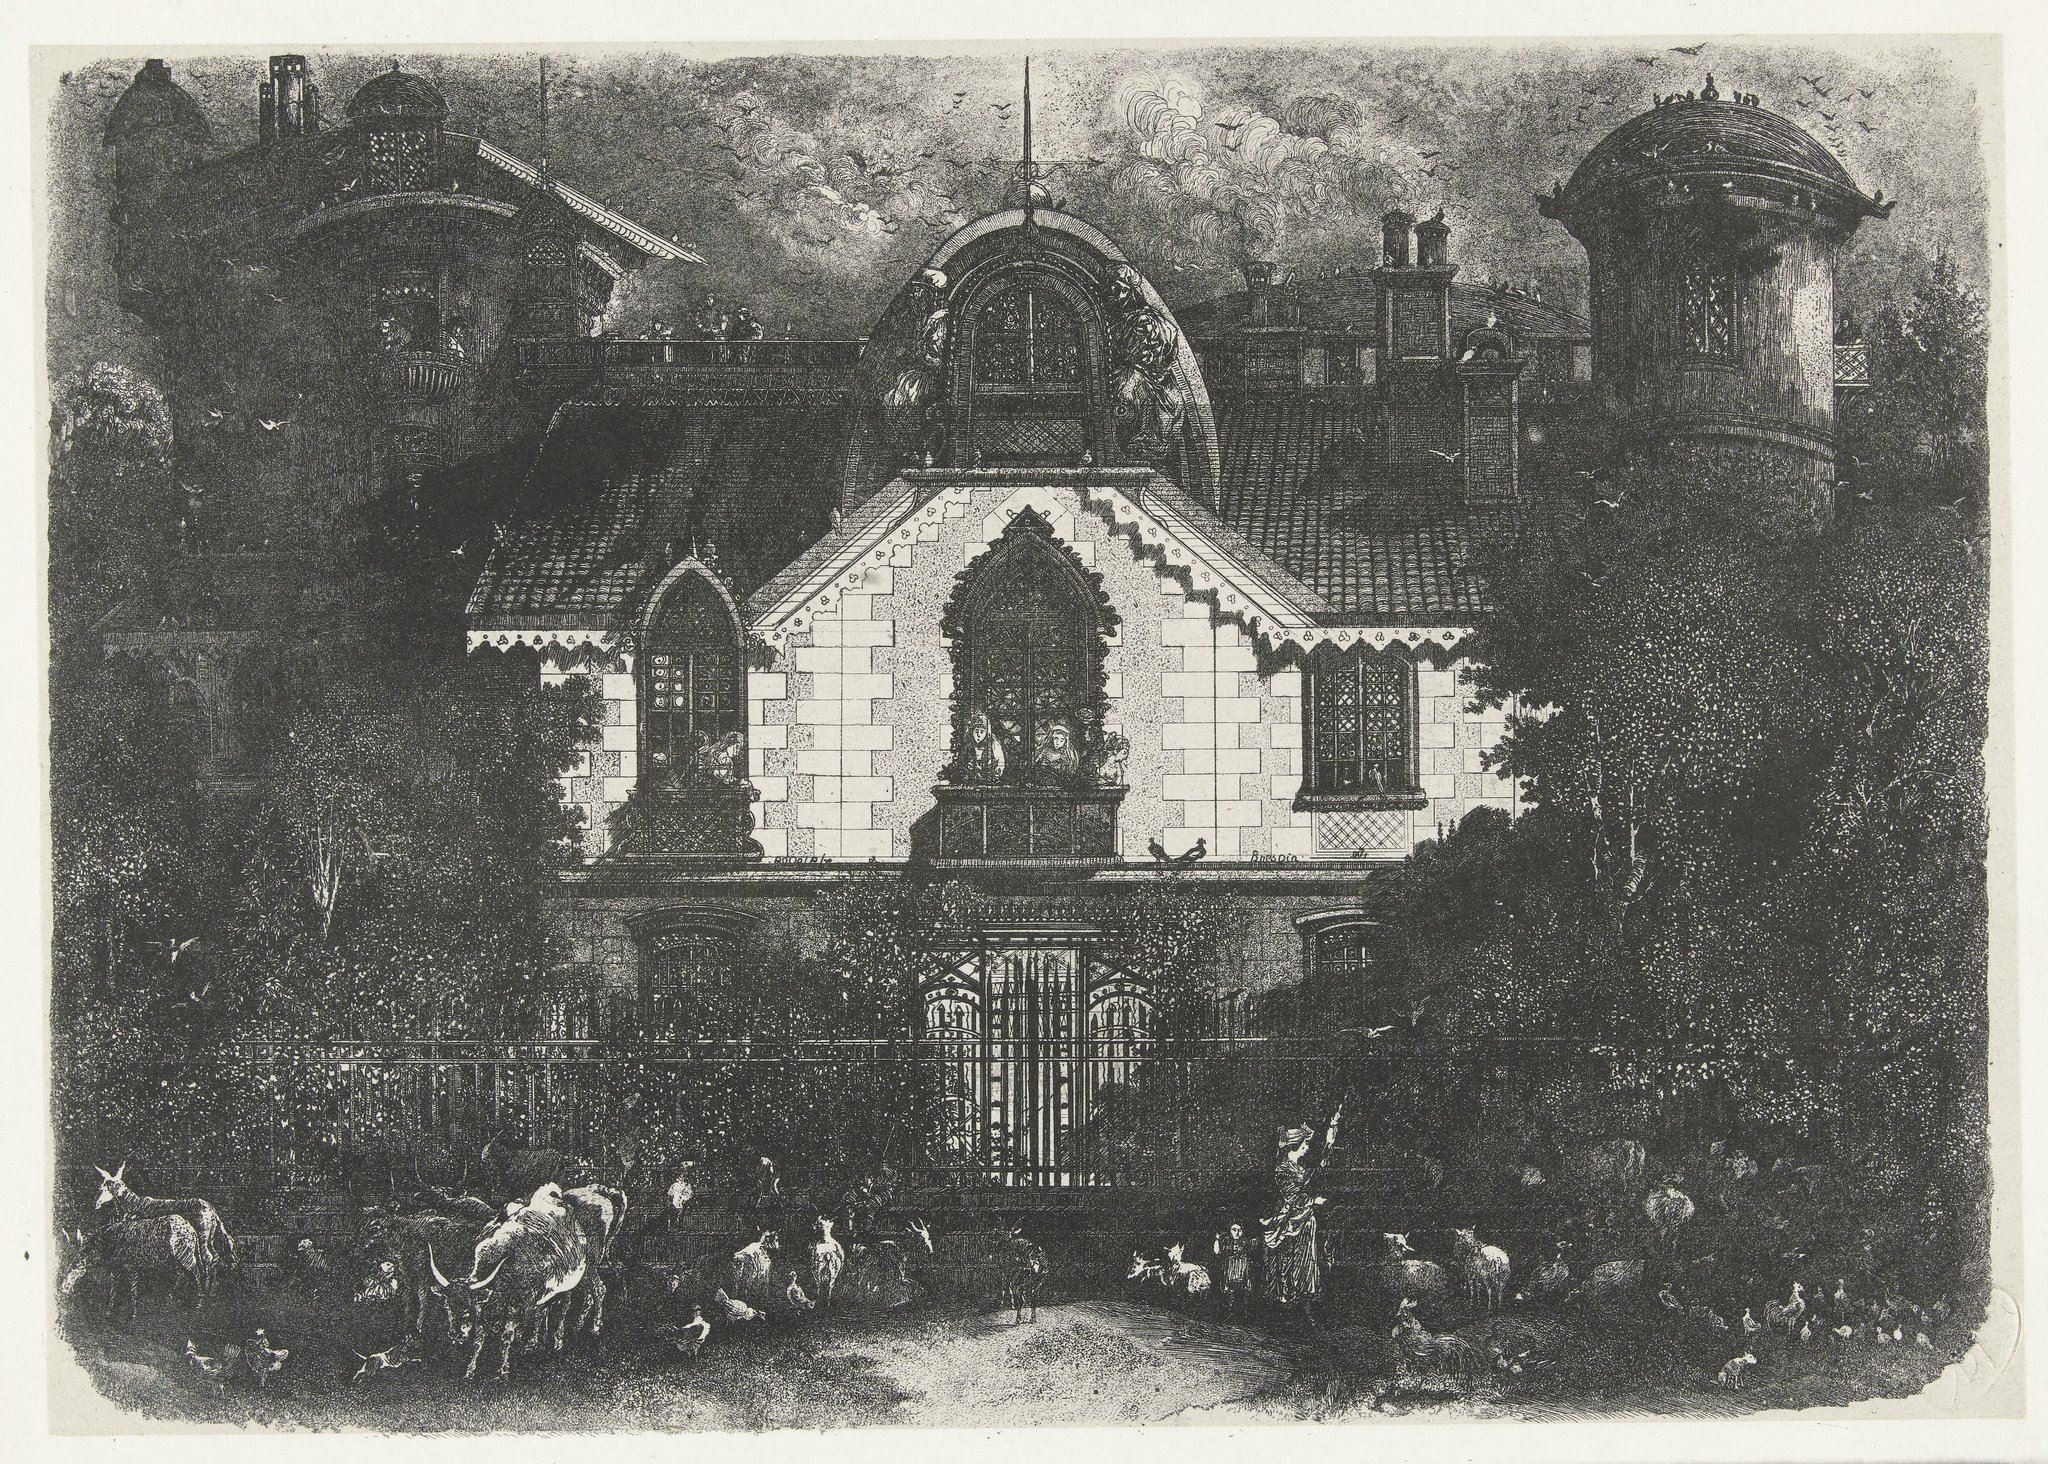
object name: print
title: La maison enchantée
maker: rodolphe bresdin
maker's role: draughtsman, print maker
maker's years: 1822-1885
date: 1871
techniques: printmaking, lithograph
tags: urban housing, herding, herdsman, herdswoman, shepherd, shepherdess, cowherd, etc., cattle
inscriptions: collector's mark: Lugt 2228, collector's mark: Lugt 2194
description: Huis met een toren achter een hek. De gevel van het pand steekt wit af tegen de donker uitgewerkte omgeving. Twee gebeeldhouwde figuren sieren de gevel aan weerszijden van het dakraam onder een halfronde daklijst. Op de balkons staan vrouwen en overal zitten en vliegen duiven op en rond het huis. Voor het hek loopt een herderin met een spinrokken en een kind omringd door vee.